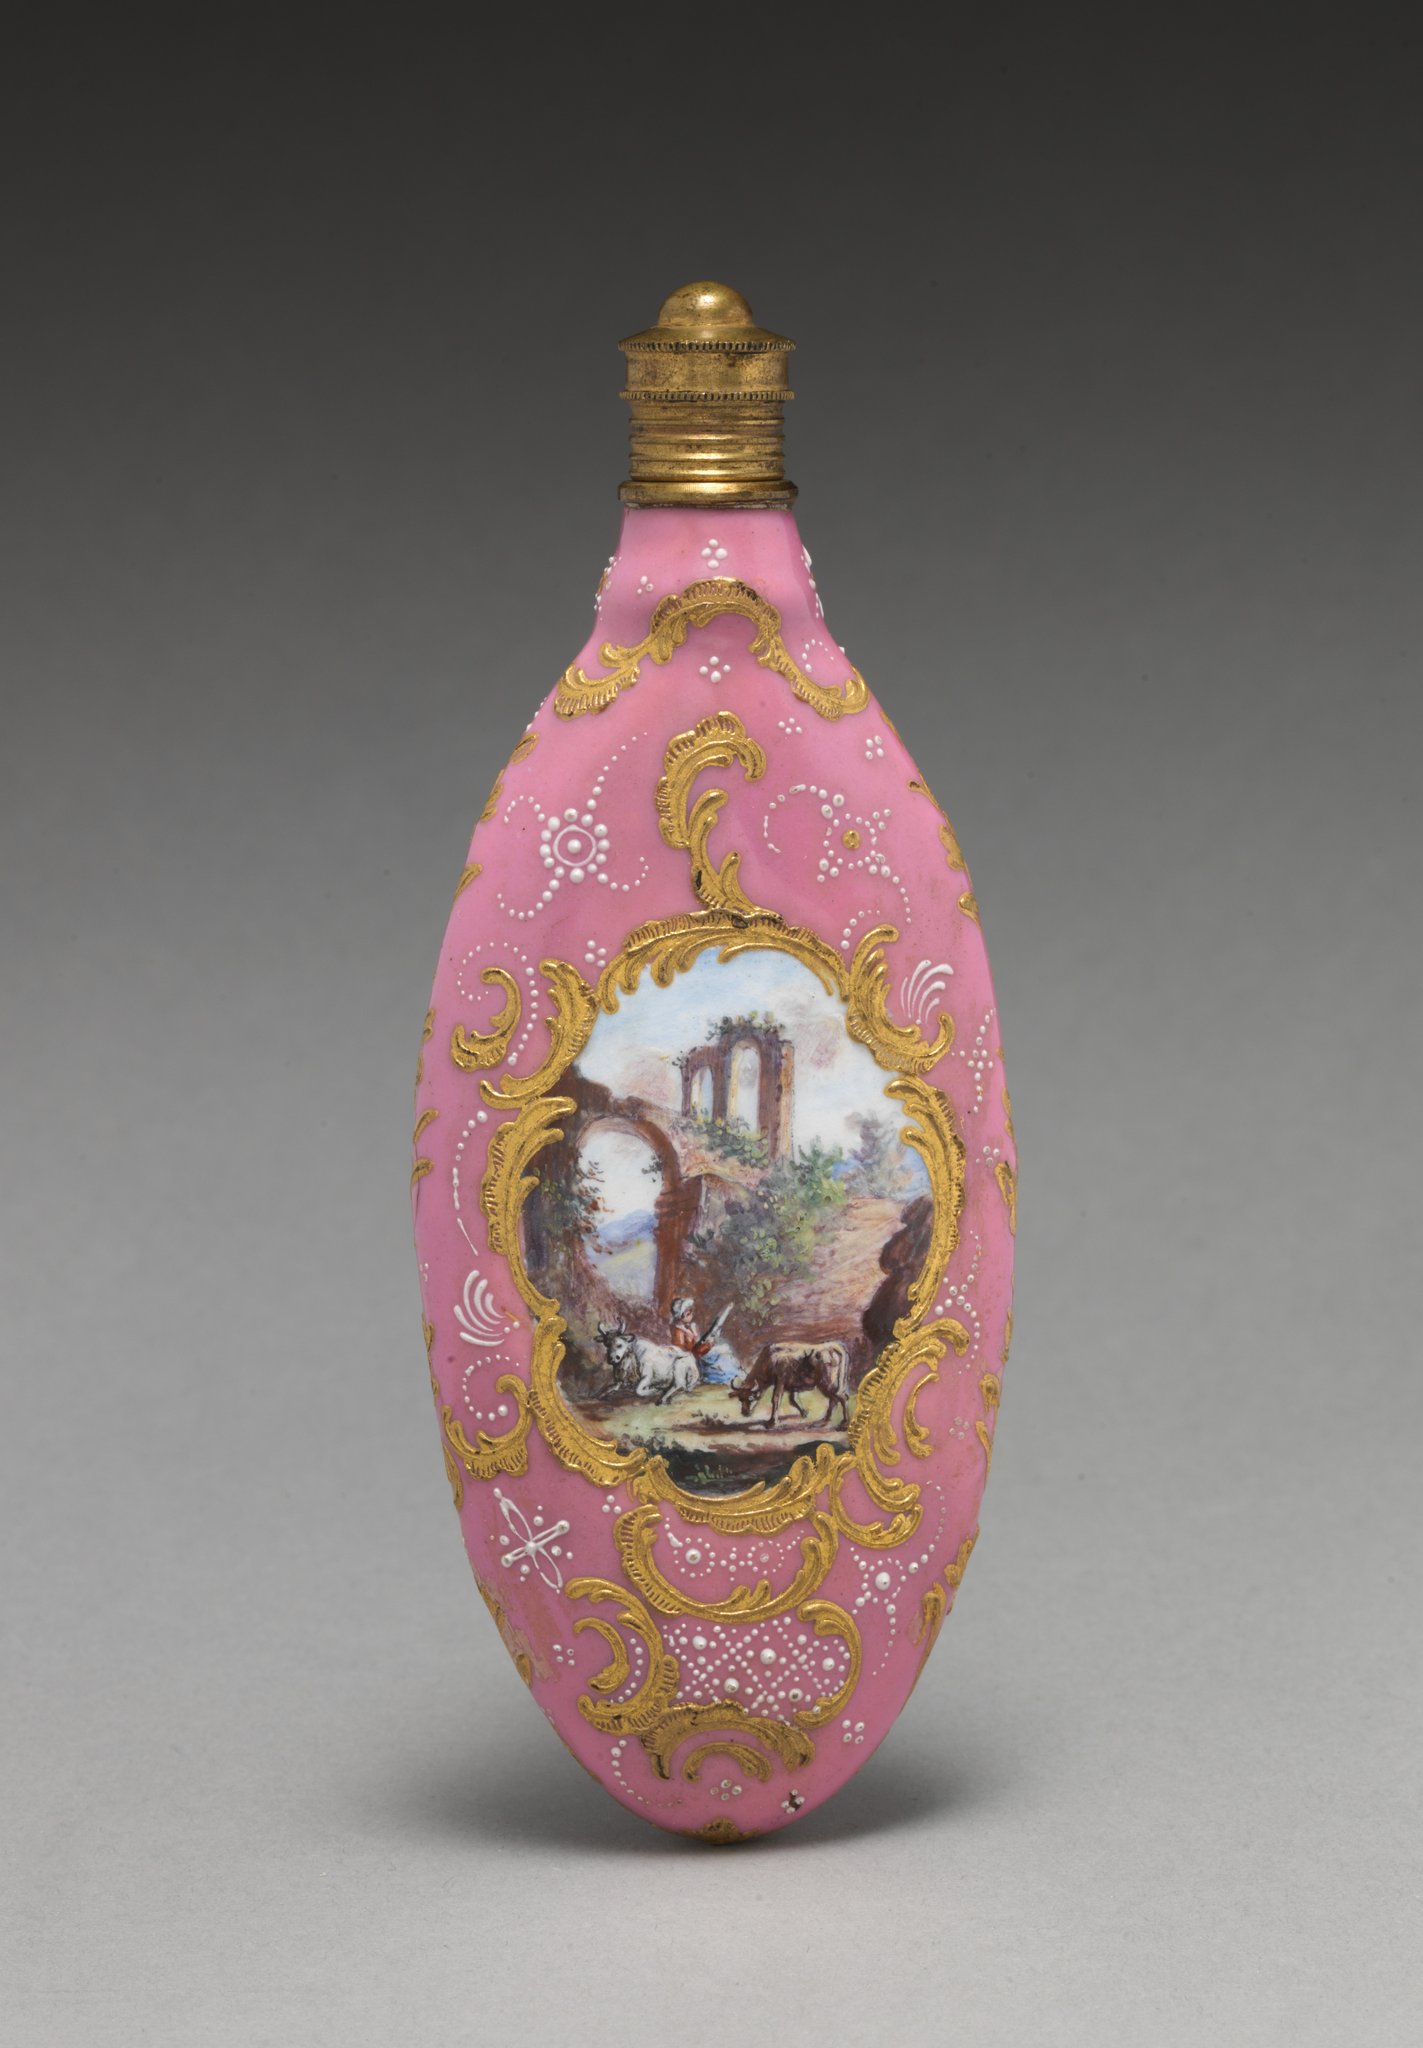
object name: scent bottle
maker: samson and company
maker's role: manufactory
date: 1870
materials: copper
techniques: enamel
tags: human figures,buildings